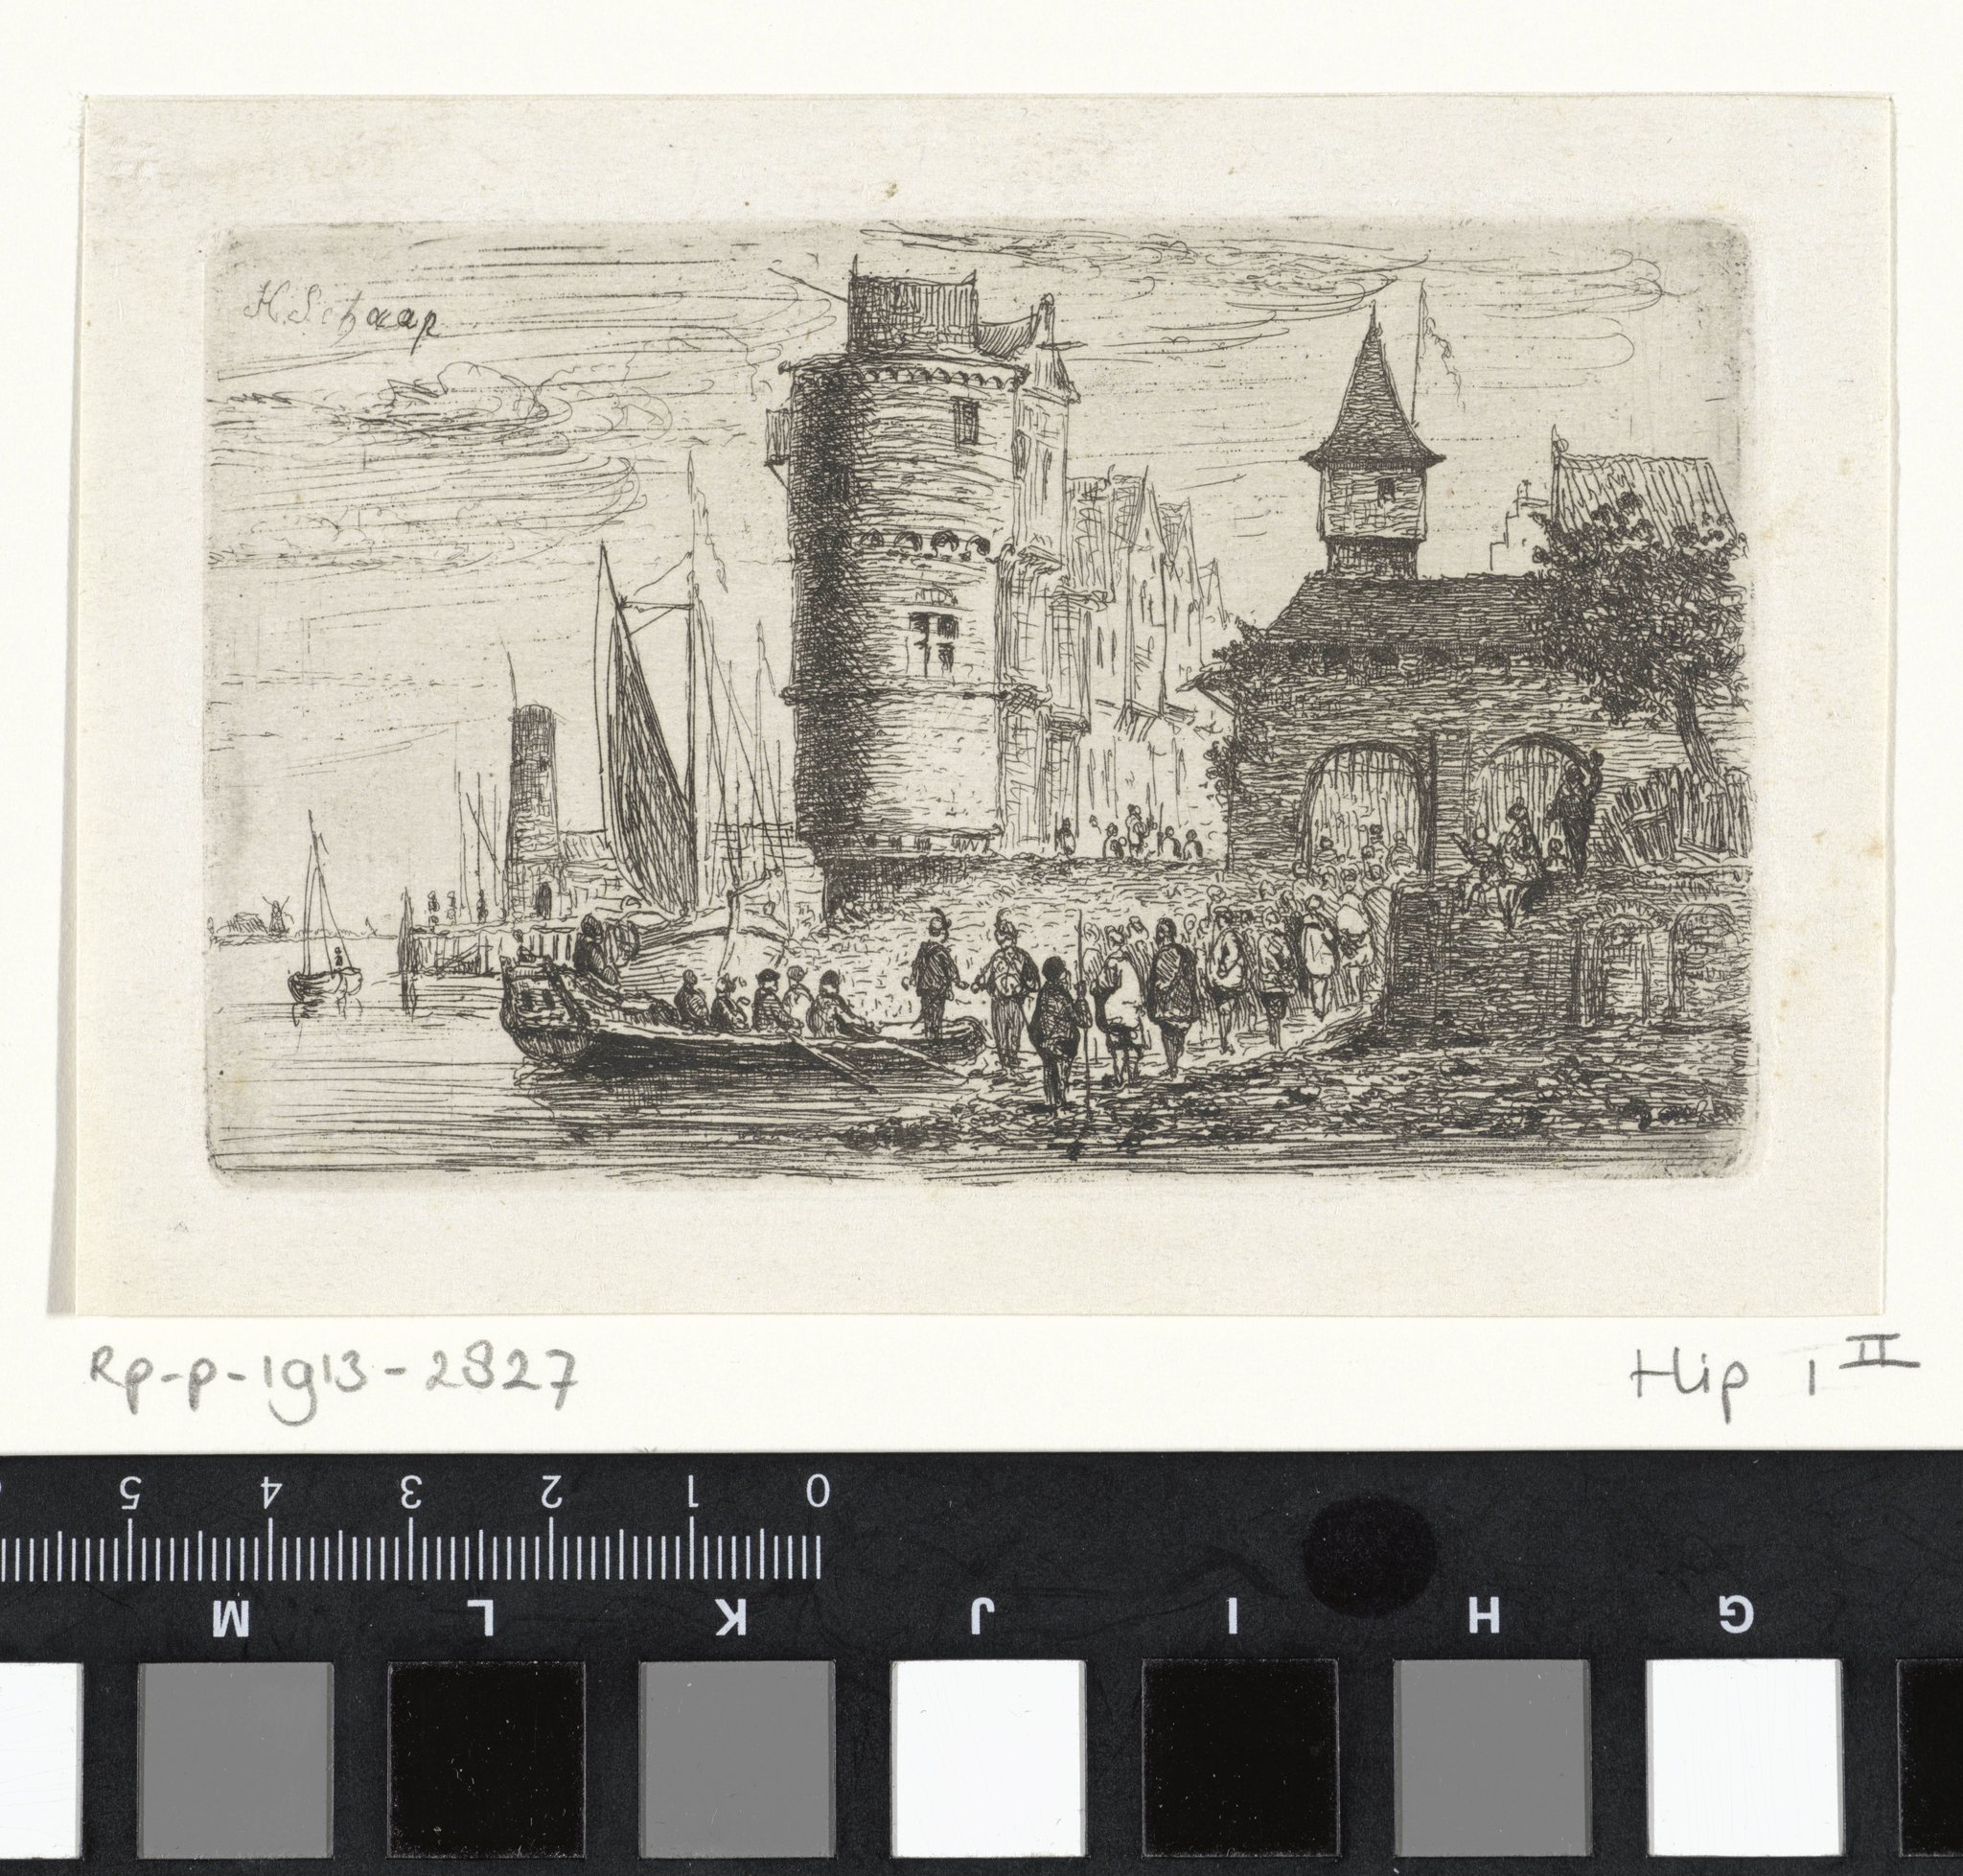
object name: print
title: Ontvangst van passagiers op een schip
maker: henri adolphe schaep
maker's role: draughtsman, painter, print maker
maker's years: 1826-1870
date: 1841-1870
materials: paper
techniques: etching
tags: landscapes with waters, waterscapes, seascapes (in the temperate zone)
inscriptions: collector's mark: Lugt 1485